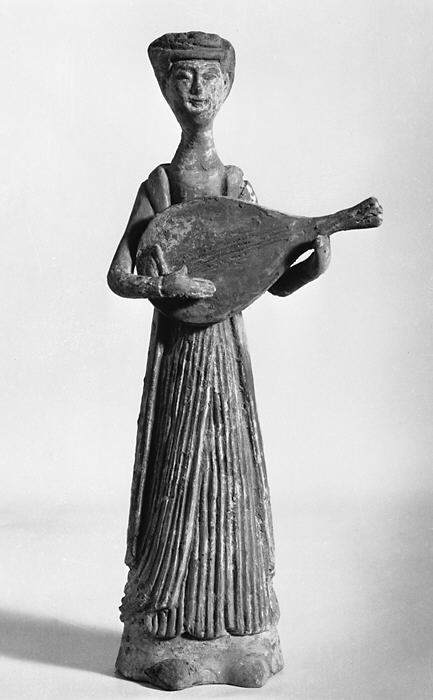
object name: figure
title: Female musician with a lute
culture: chinese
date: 501-600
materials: earthenware, pigment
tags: musical instruments